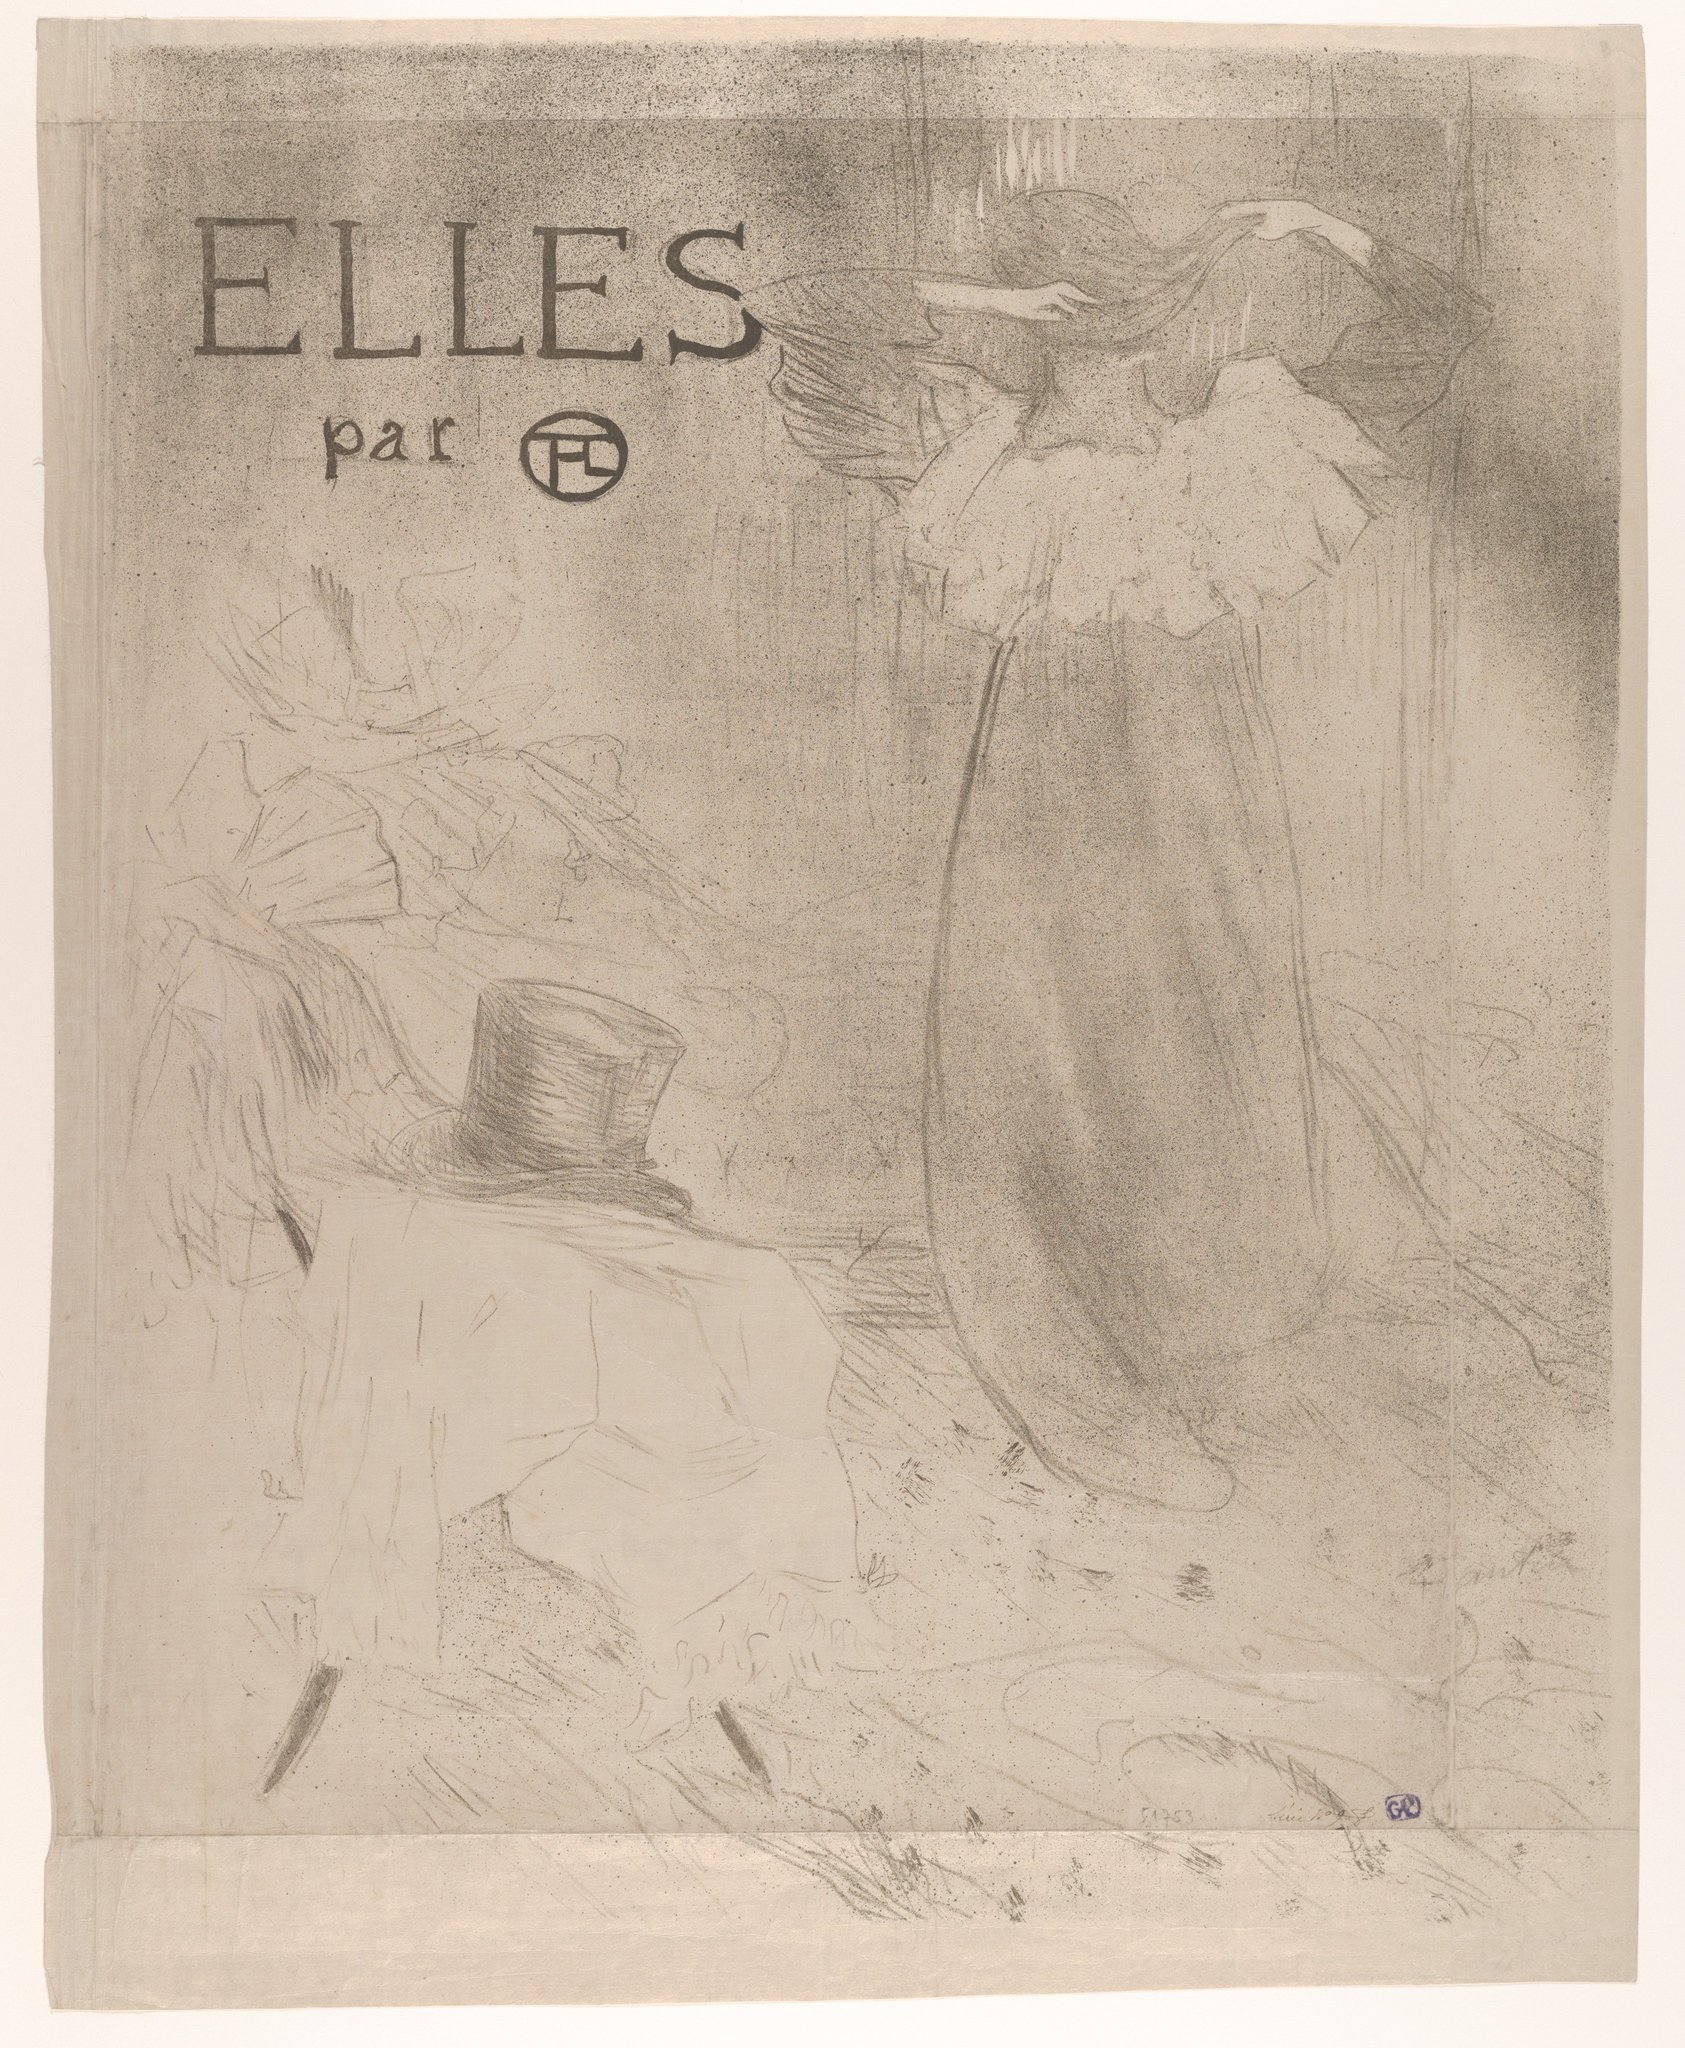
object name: print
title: Elles (portfolio cover)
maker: henri de toulouse-lautrec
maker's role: artist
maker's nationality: french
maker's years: 1864-1901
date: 1896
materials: crayon, paper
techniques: brush, lithograph, printing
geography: france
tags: hats,women